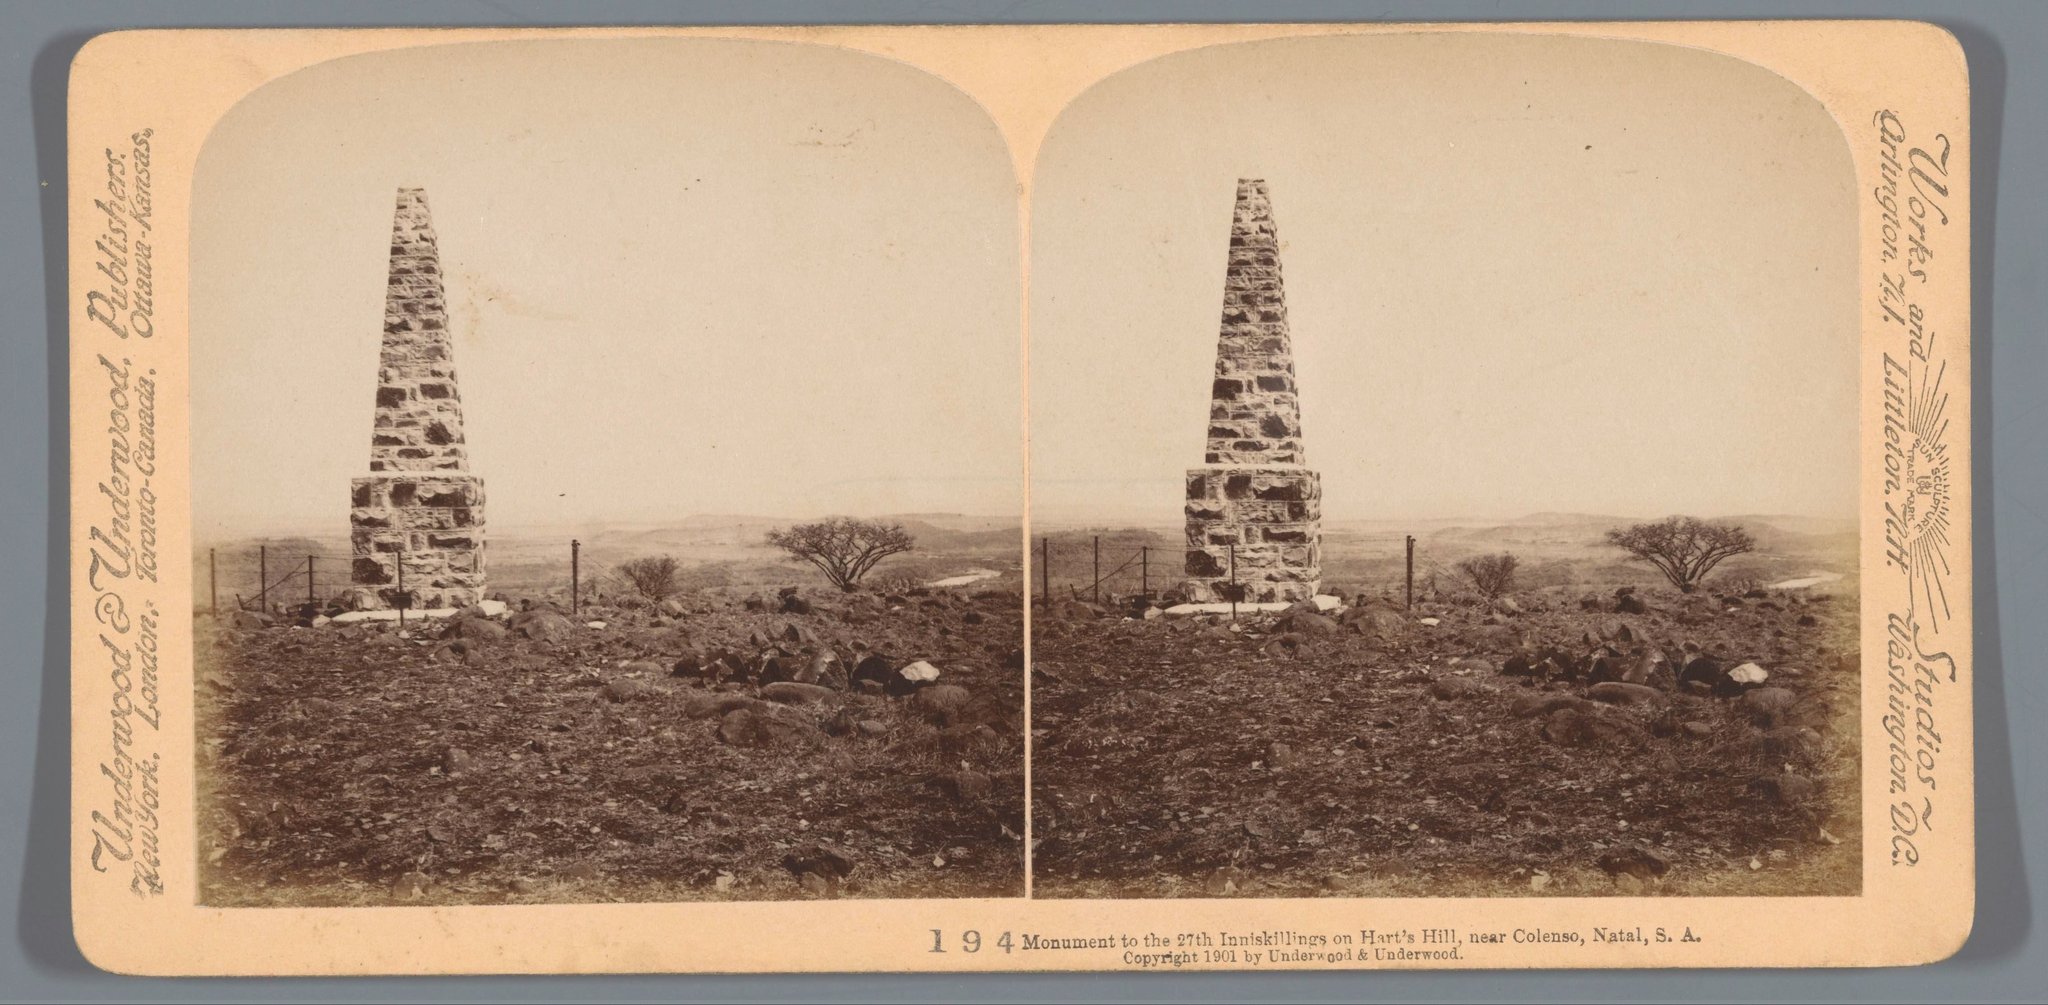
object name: stereograph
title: Oorlogsmonument ter nagedachtenis van een slag tijdens de Tweede Boerenoorlog in Zuid-Afrika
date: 1901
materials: cardboard, photographic support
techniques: albumen print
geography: south africa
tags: monument, statue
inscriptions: name: ‘Works and Studios Sun Sculpture trade mark Arlington N.J. Littleton N.H. Washington D.C.’, number: ‘194’